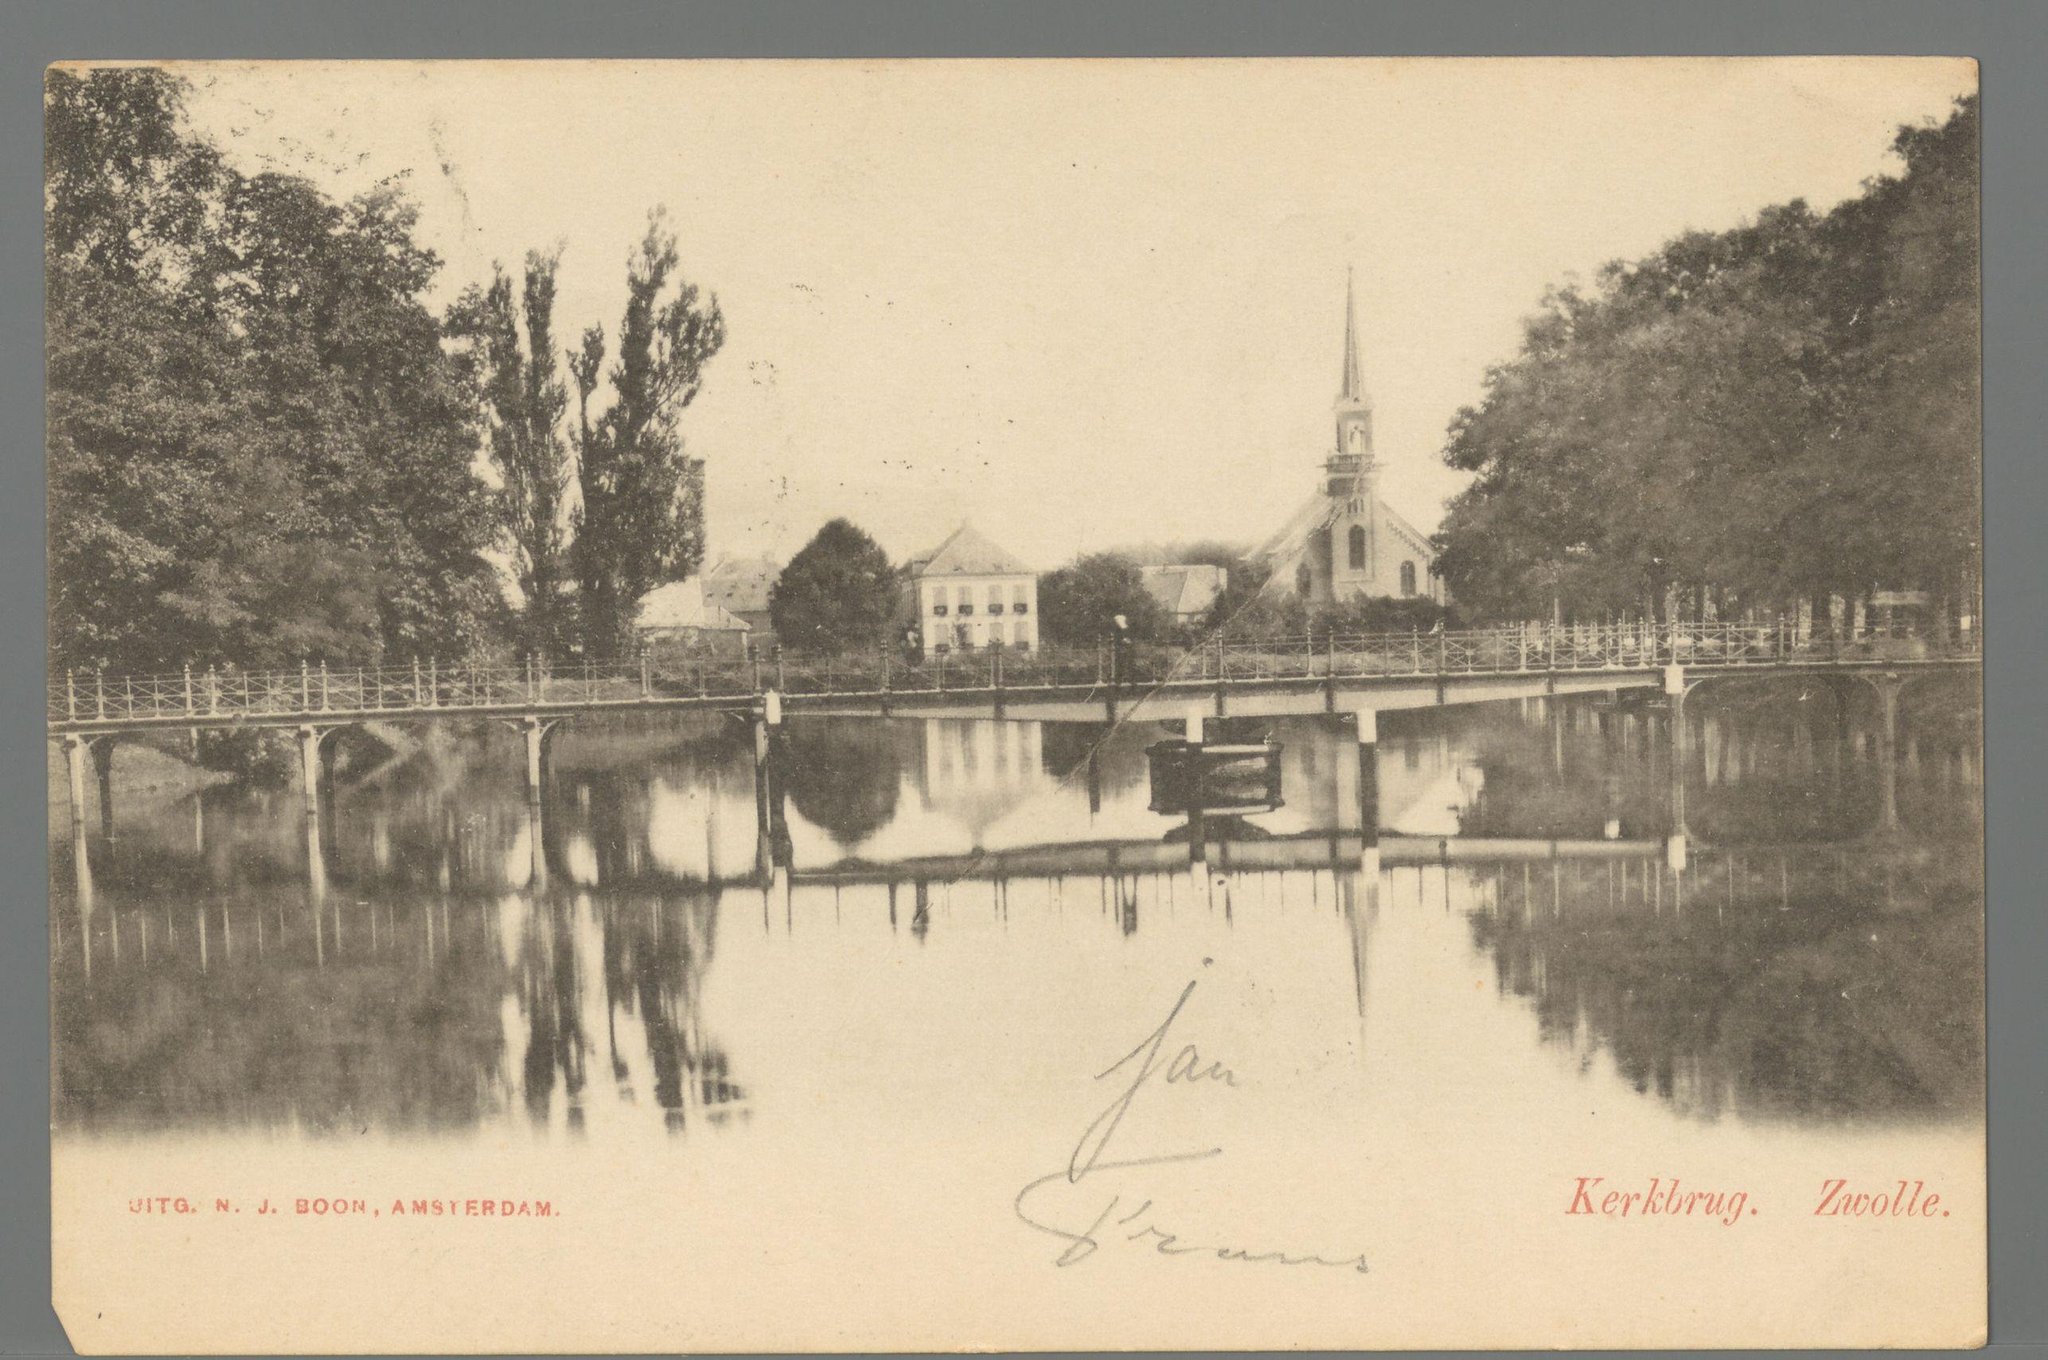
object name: ansichtkaart, prentbriefkaart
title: Kerkbrug. Zwolle.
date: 1897-1905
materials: cardboard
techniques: photograph, writing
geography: breda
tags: bridge in city across river, canal, etc.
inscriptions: postage stamp